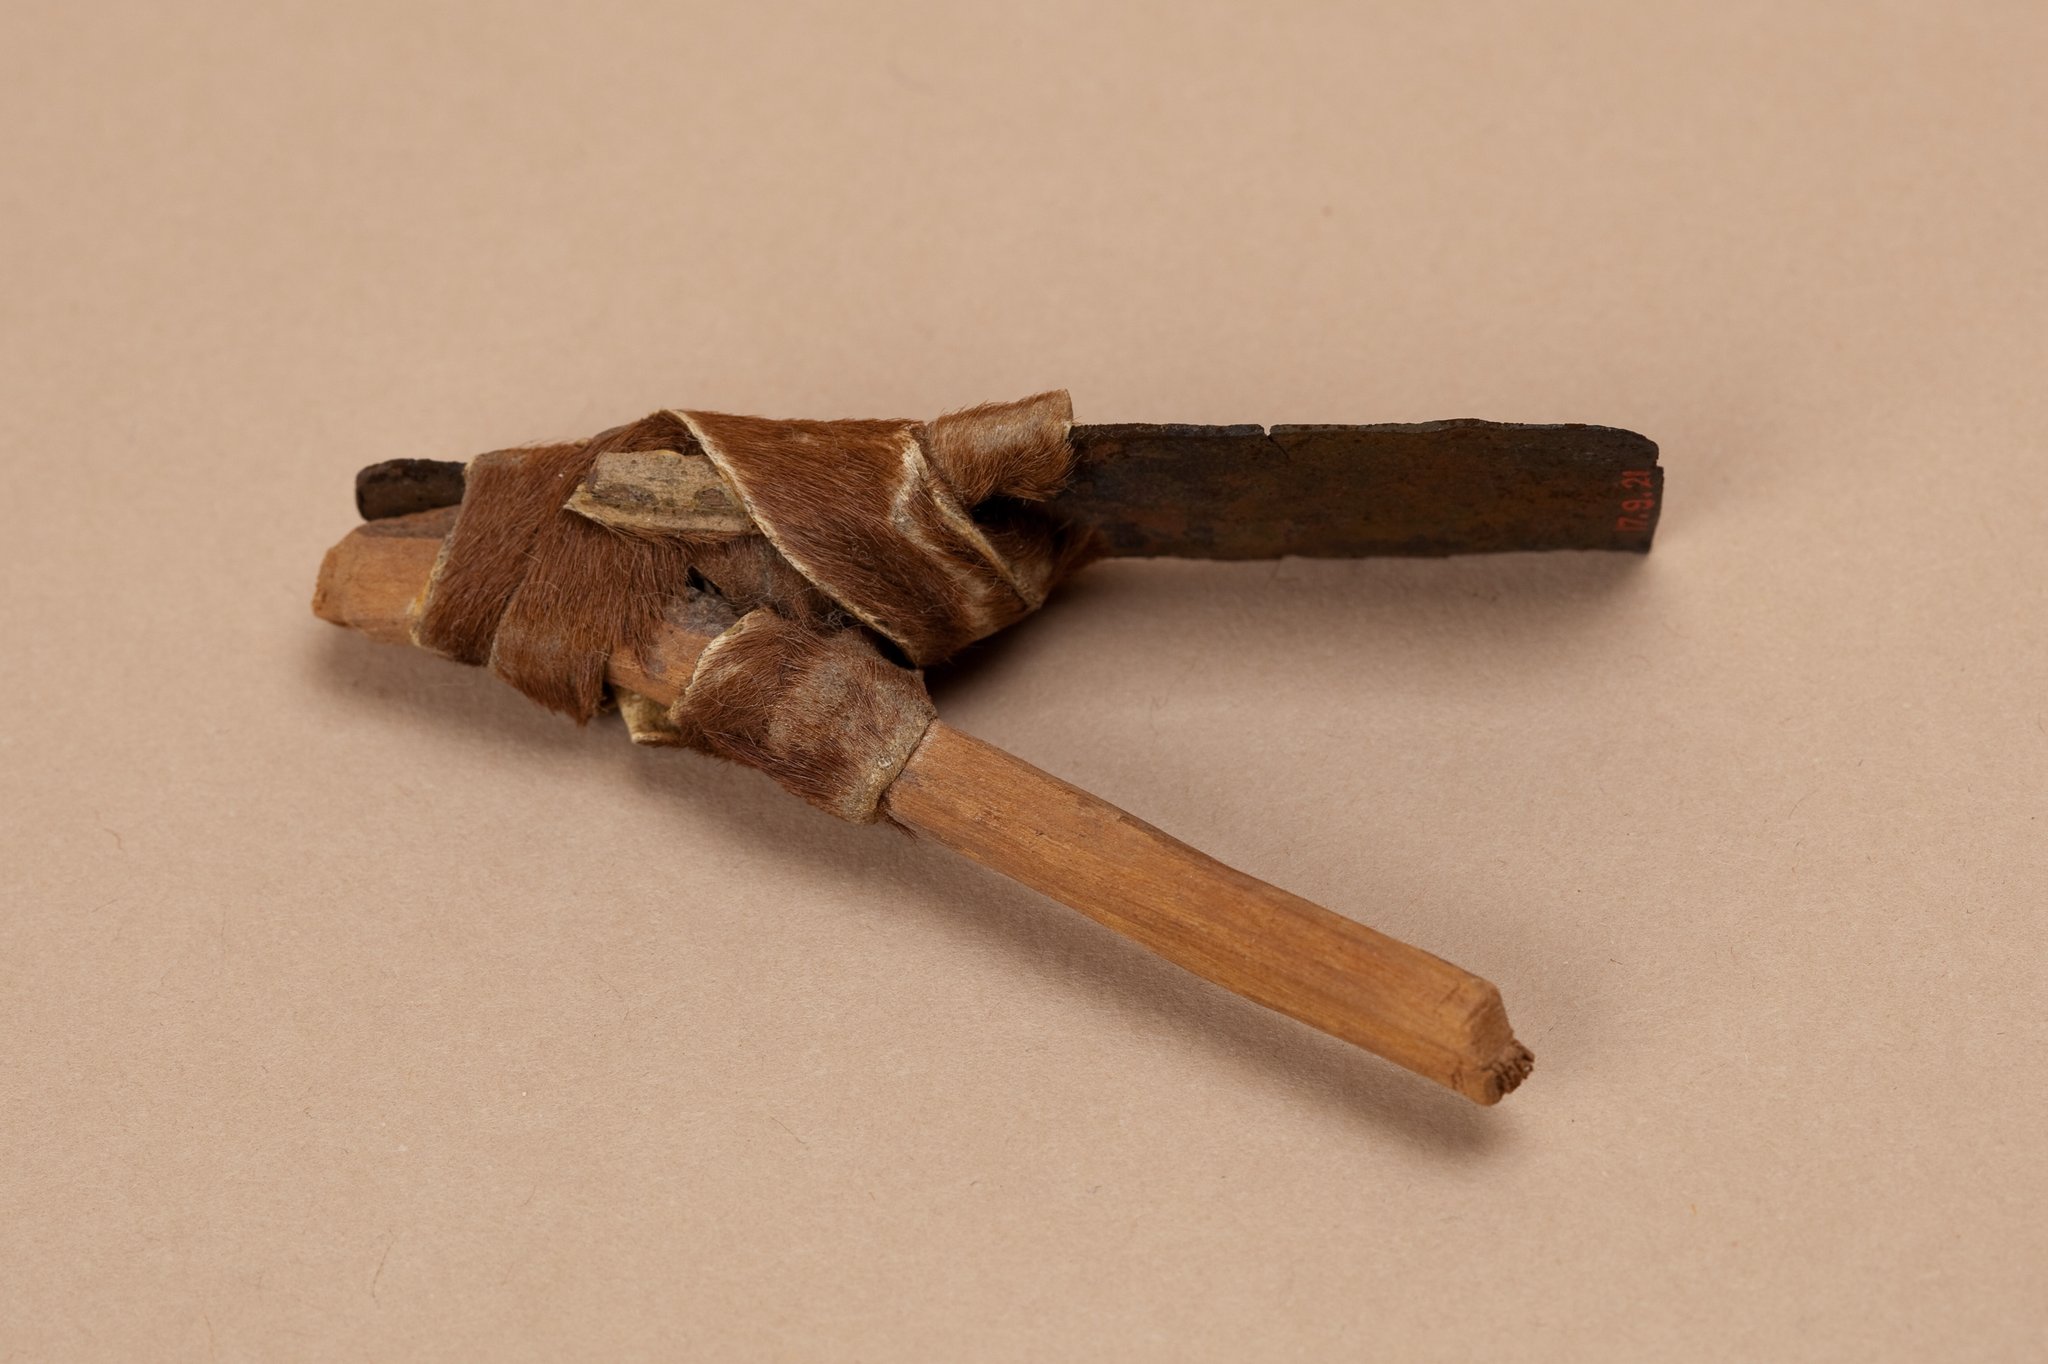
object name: model adze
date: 1981-1802 BCE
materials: copper, wood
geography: egypt